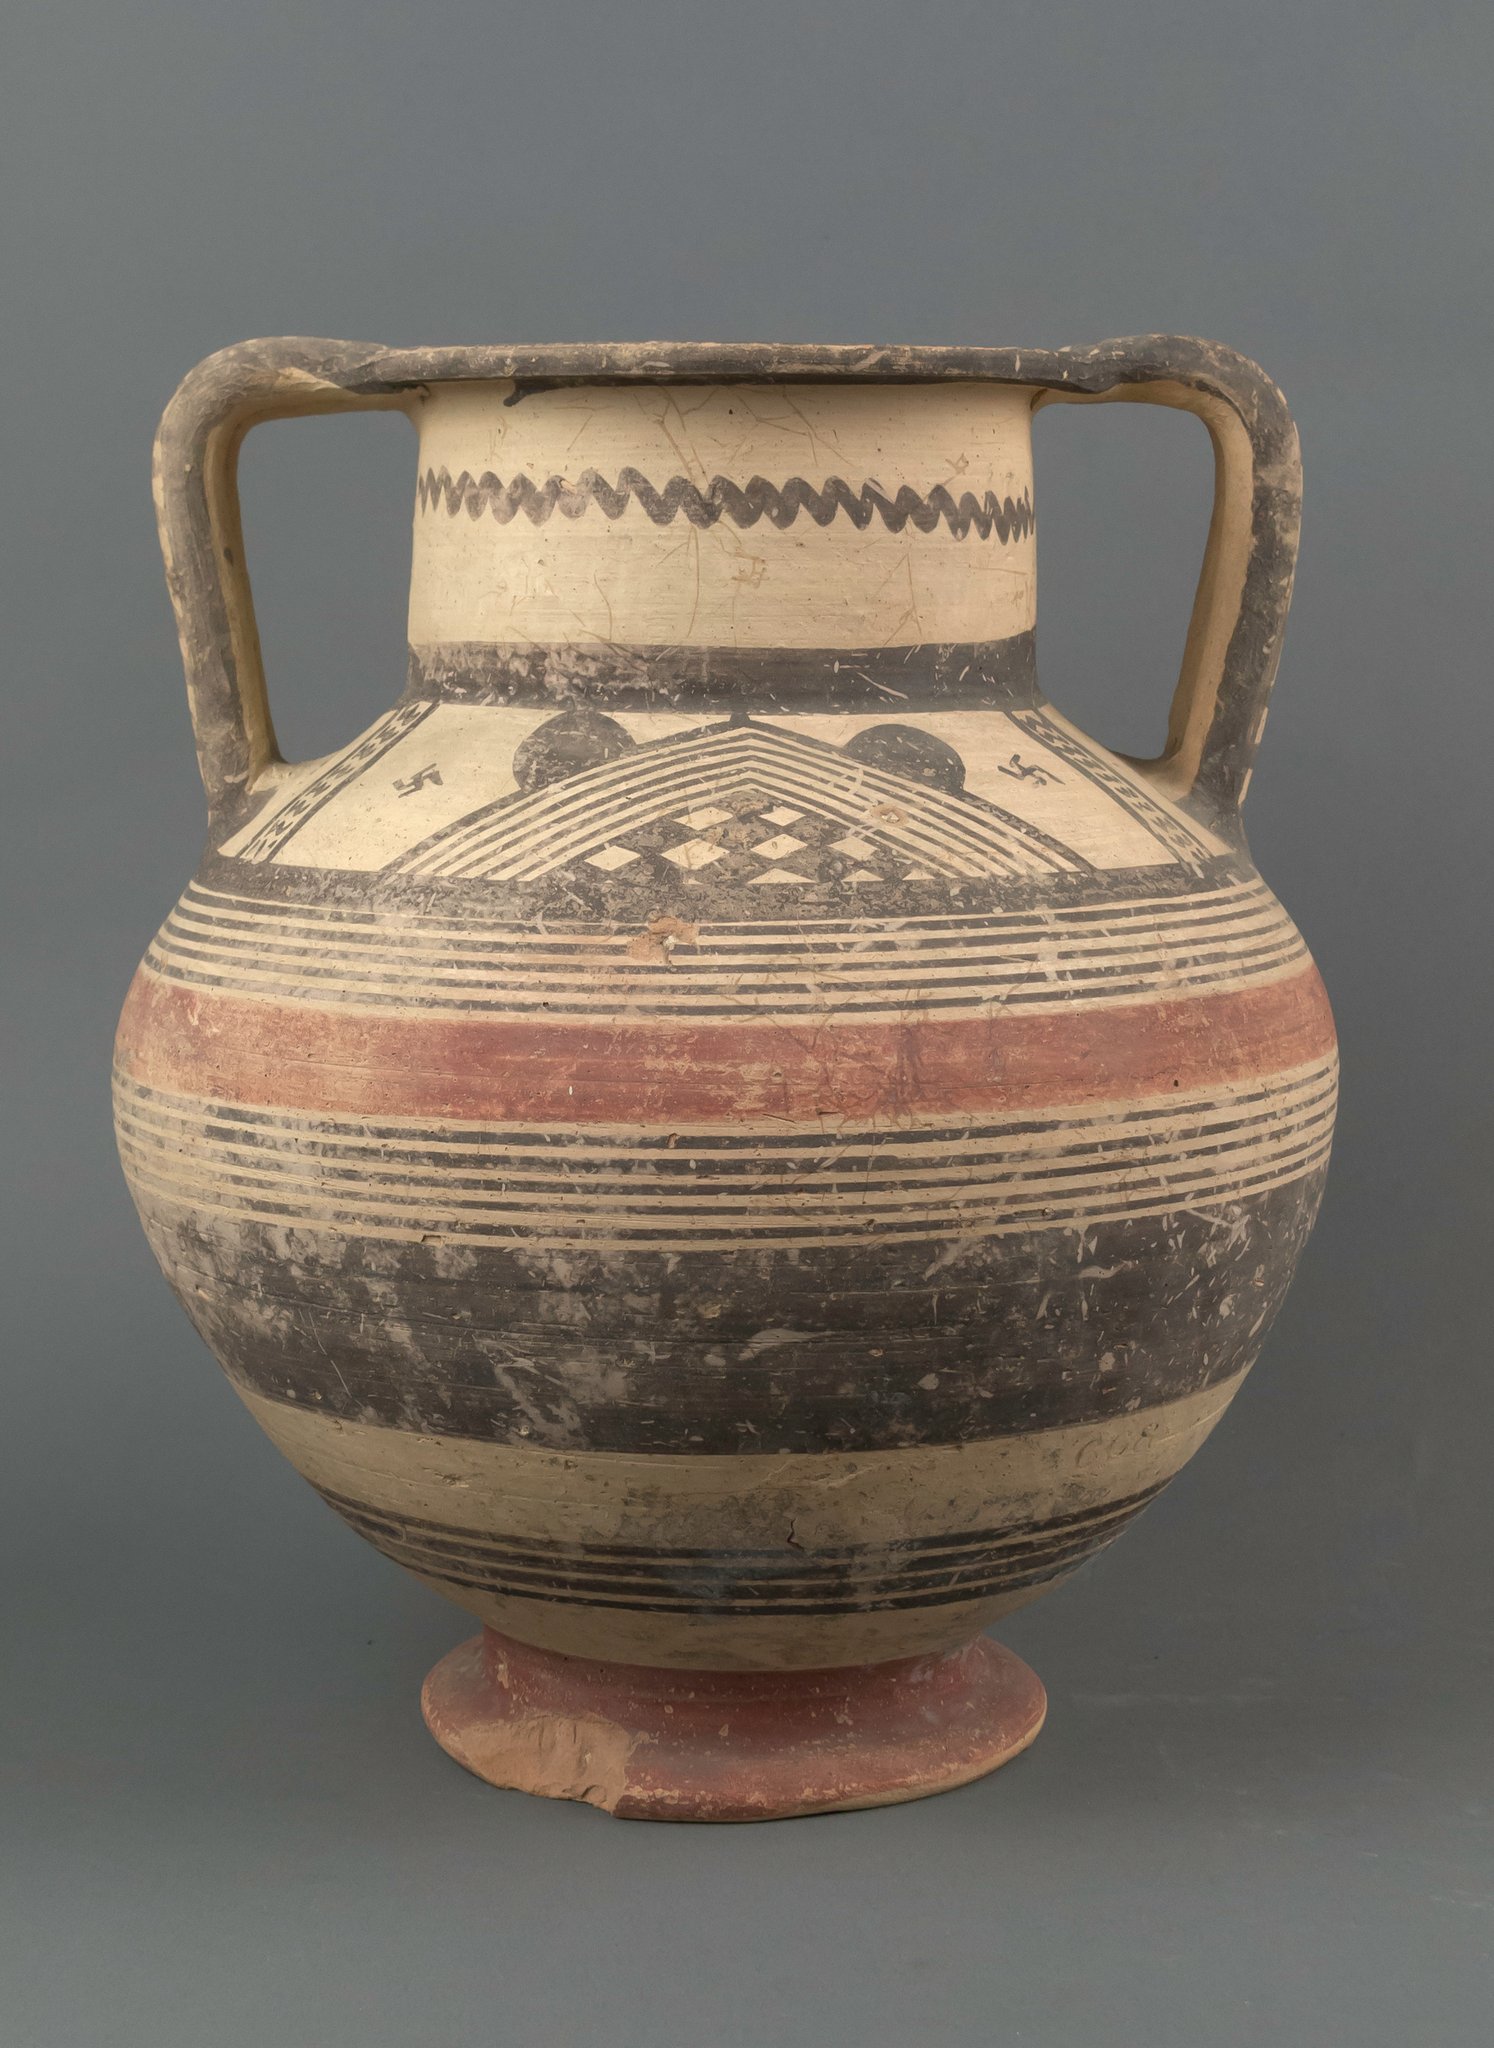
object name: amphora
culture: cypriot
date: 750-600 BCE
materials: terracotta